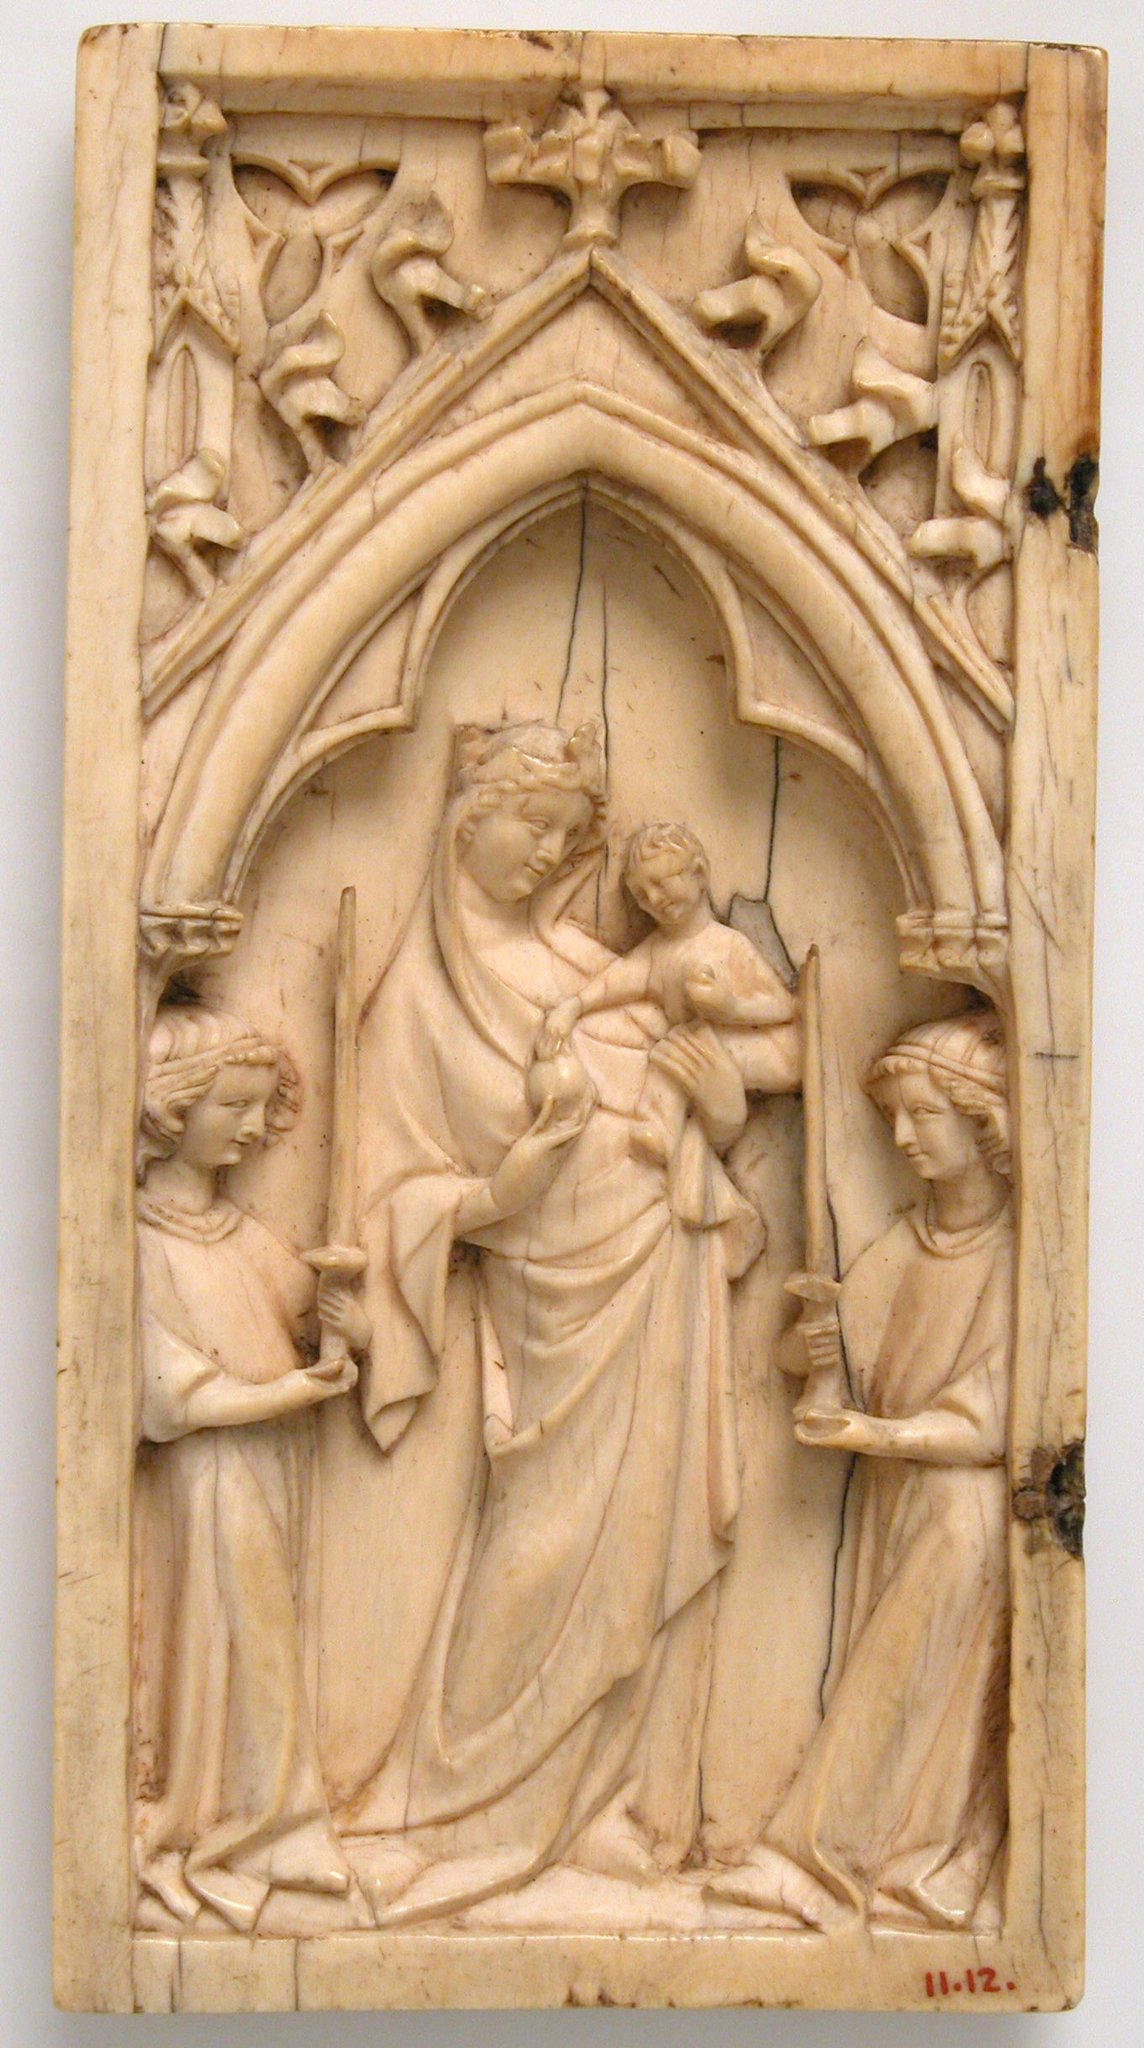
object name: diptych leaf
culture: french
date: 1301-1400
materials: ivory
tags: swords,men,madonna and child